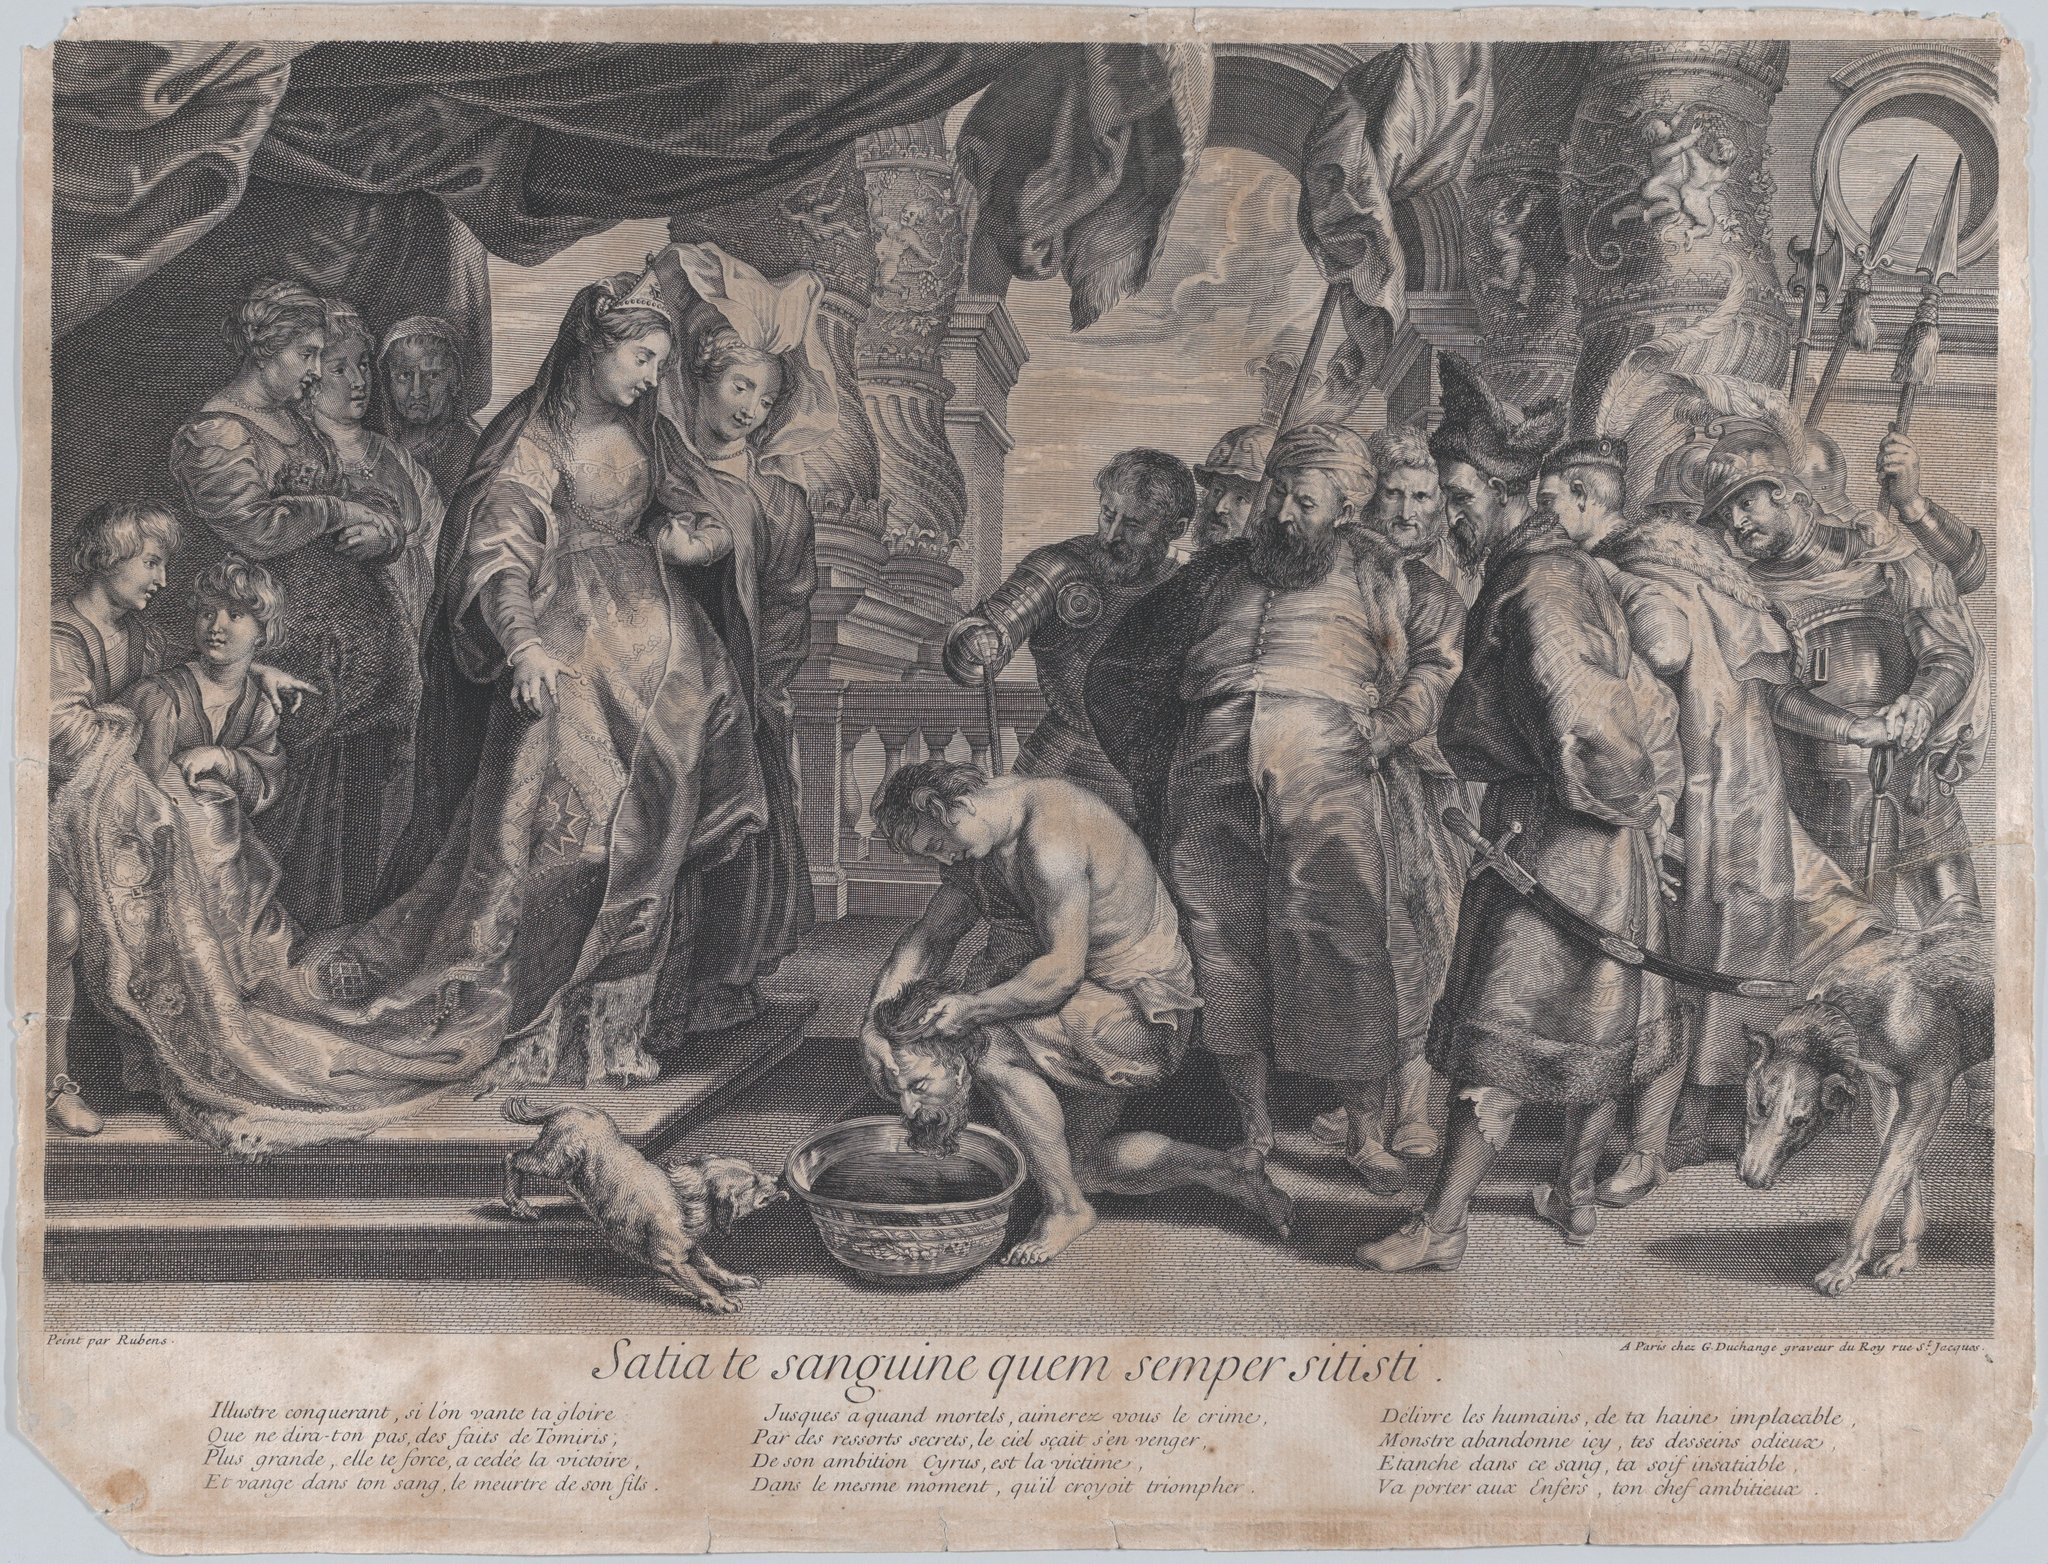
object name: print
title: The Head of Cyrus brought to Queen Tomyris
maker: gaspard duchange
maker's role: artist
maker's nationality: french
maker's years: 1662-1757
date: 1713-1720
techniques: engraving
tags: soldiers,queens,heads